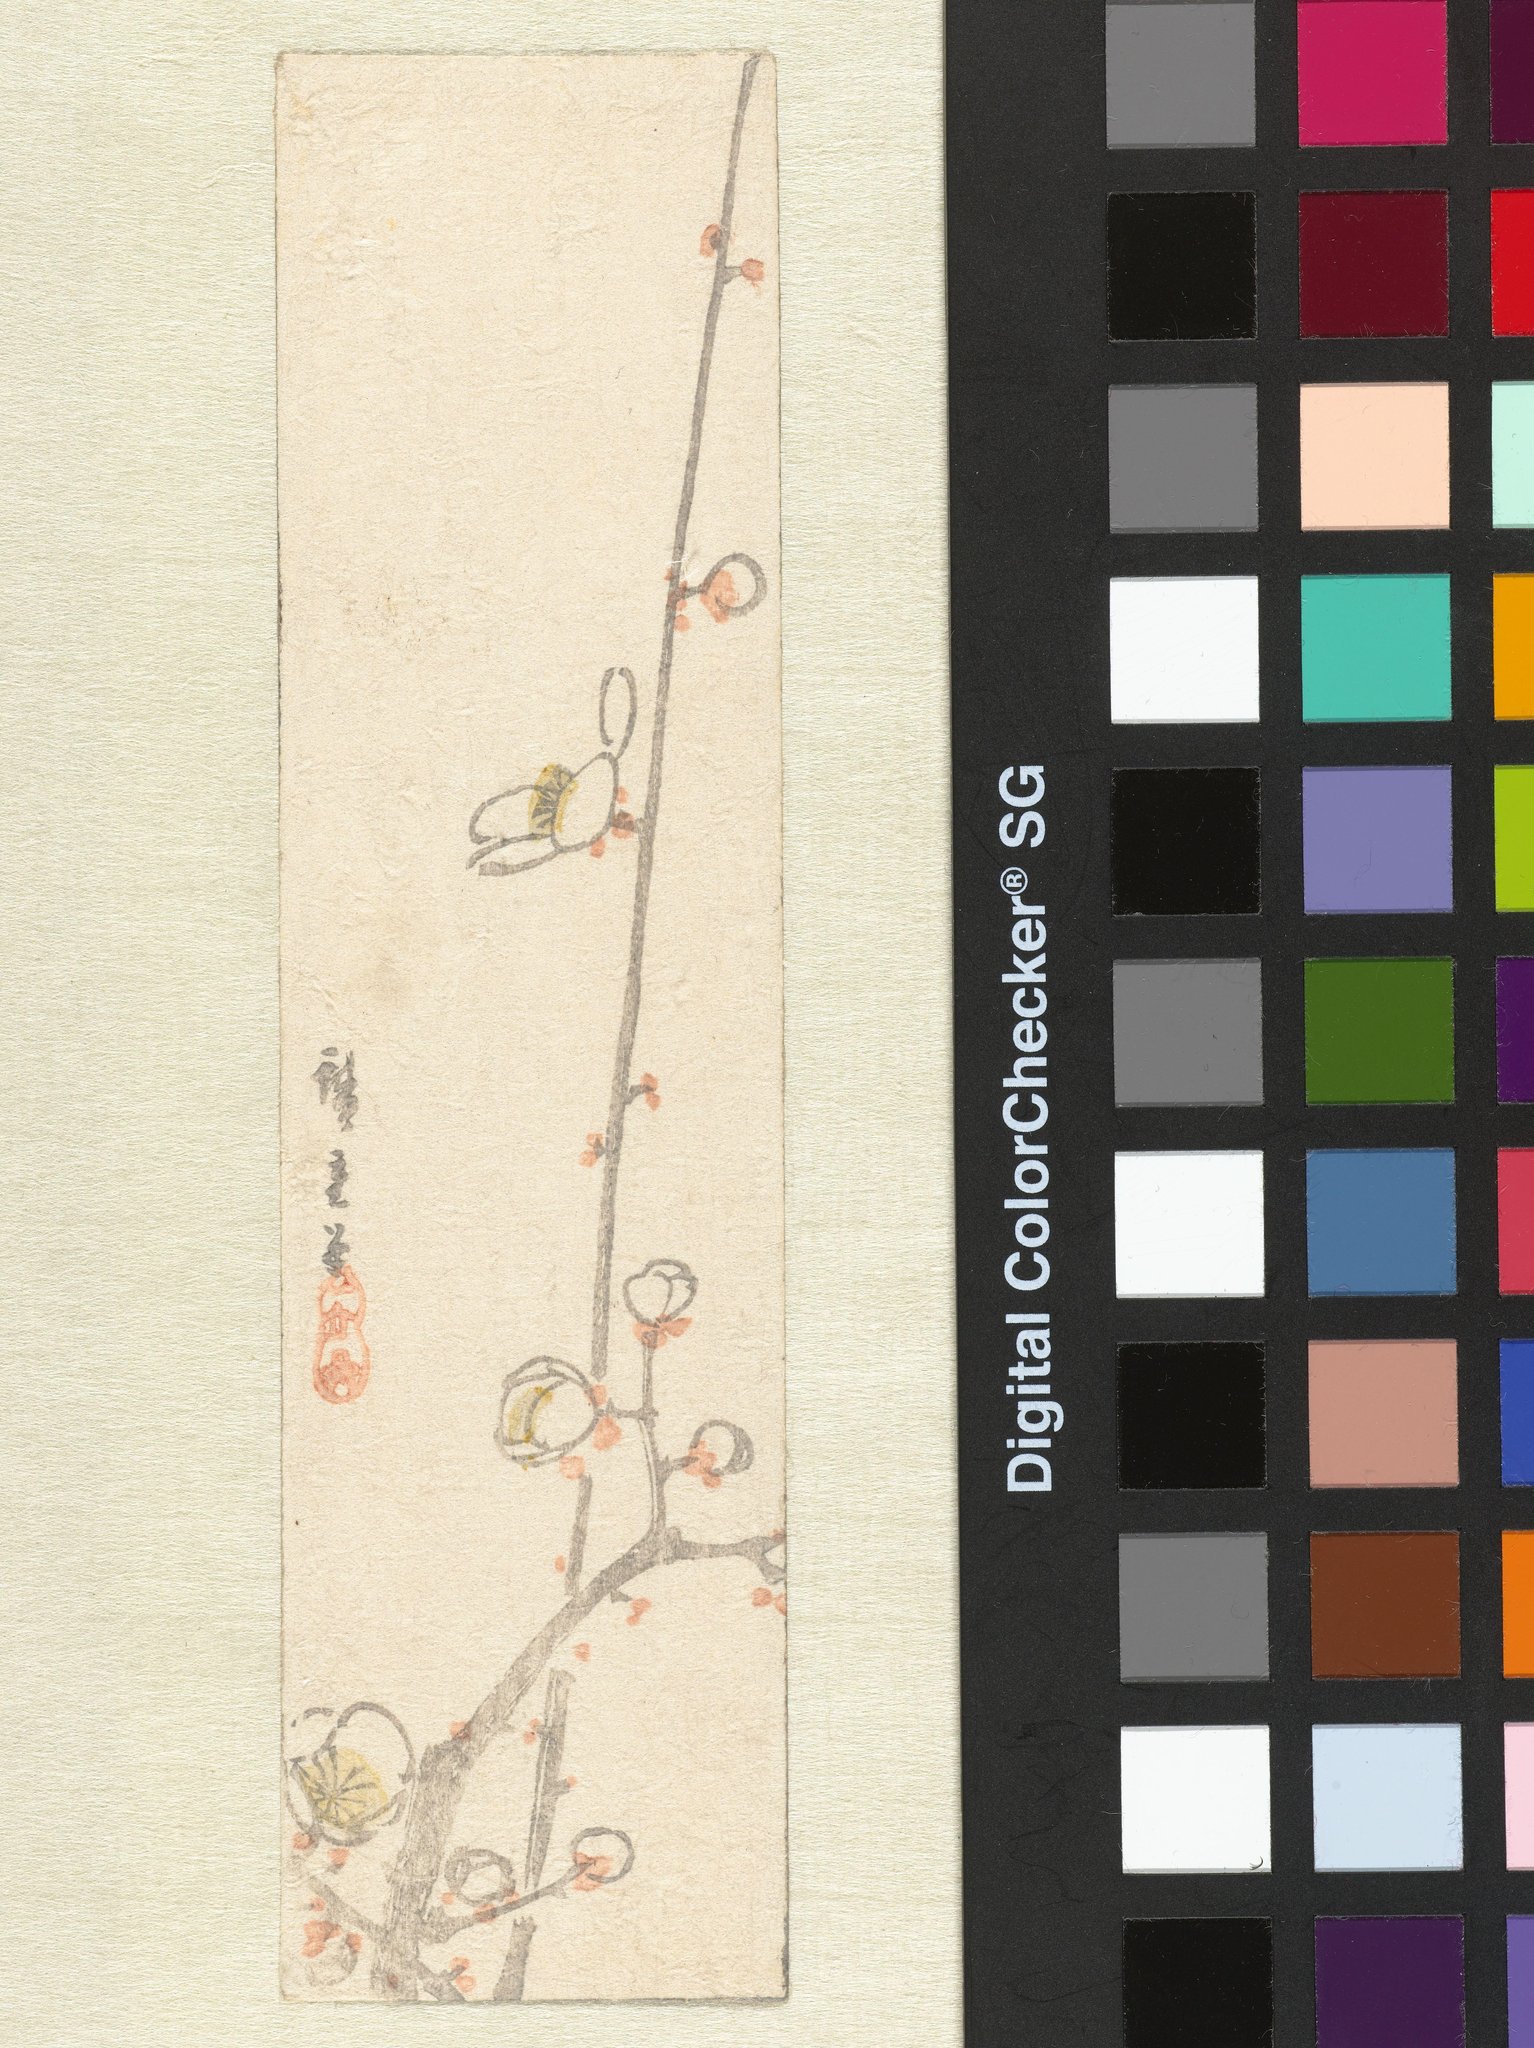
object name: print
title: Voorkant van envelop met afbeelding bloesemende pruimentakken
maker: utagawa hiroshige (i)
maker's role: draughtsman, print maker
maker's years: 1797-1858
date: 1845-1850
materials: paper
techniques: woodcut, nishiki e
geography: japan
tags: flowers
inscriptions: collector's mark: Lugt 2228